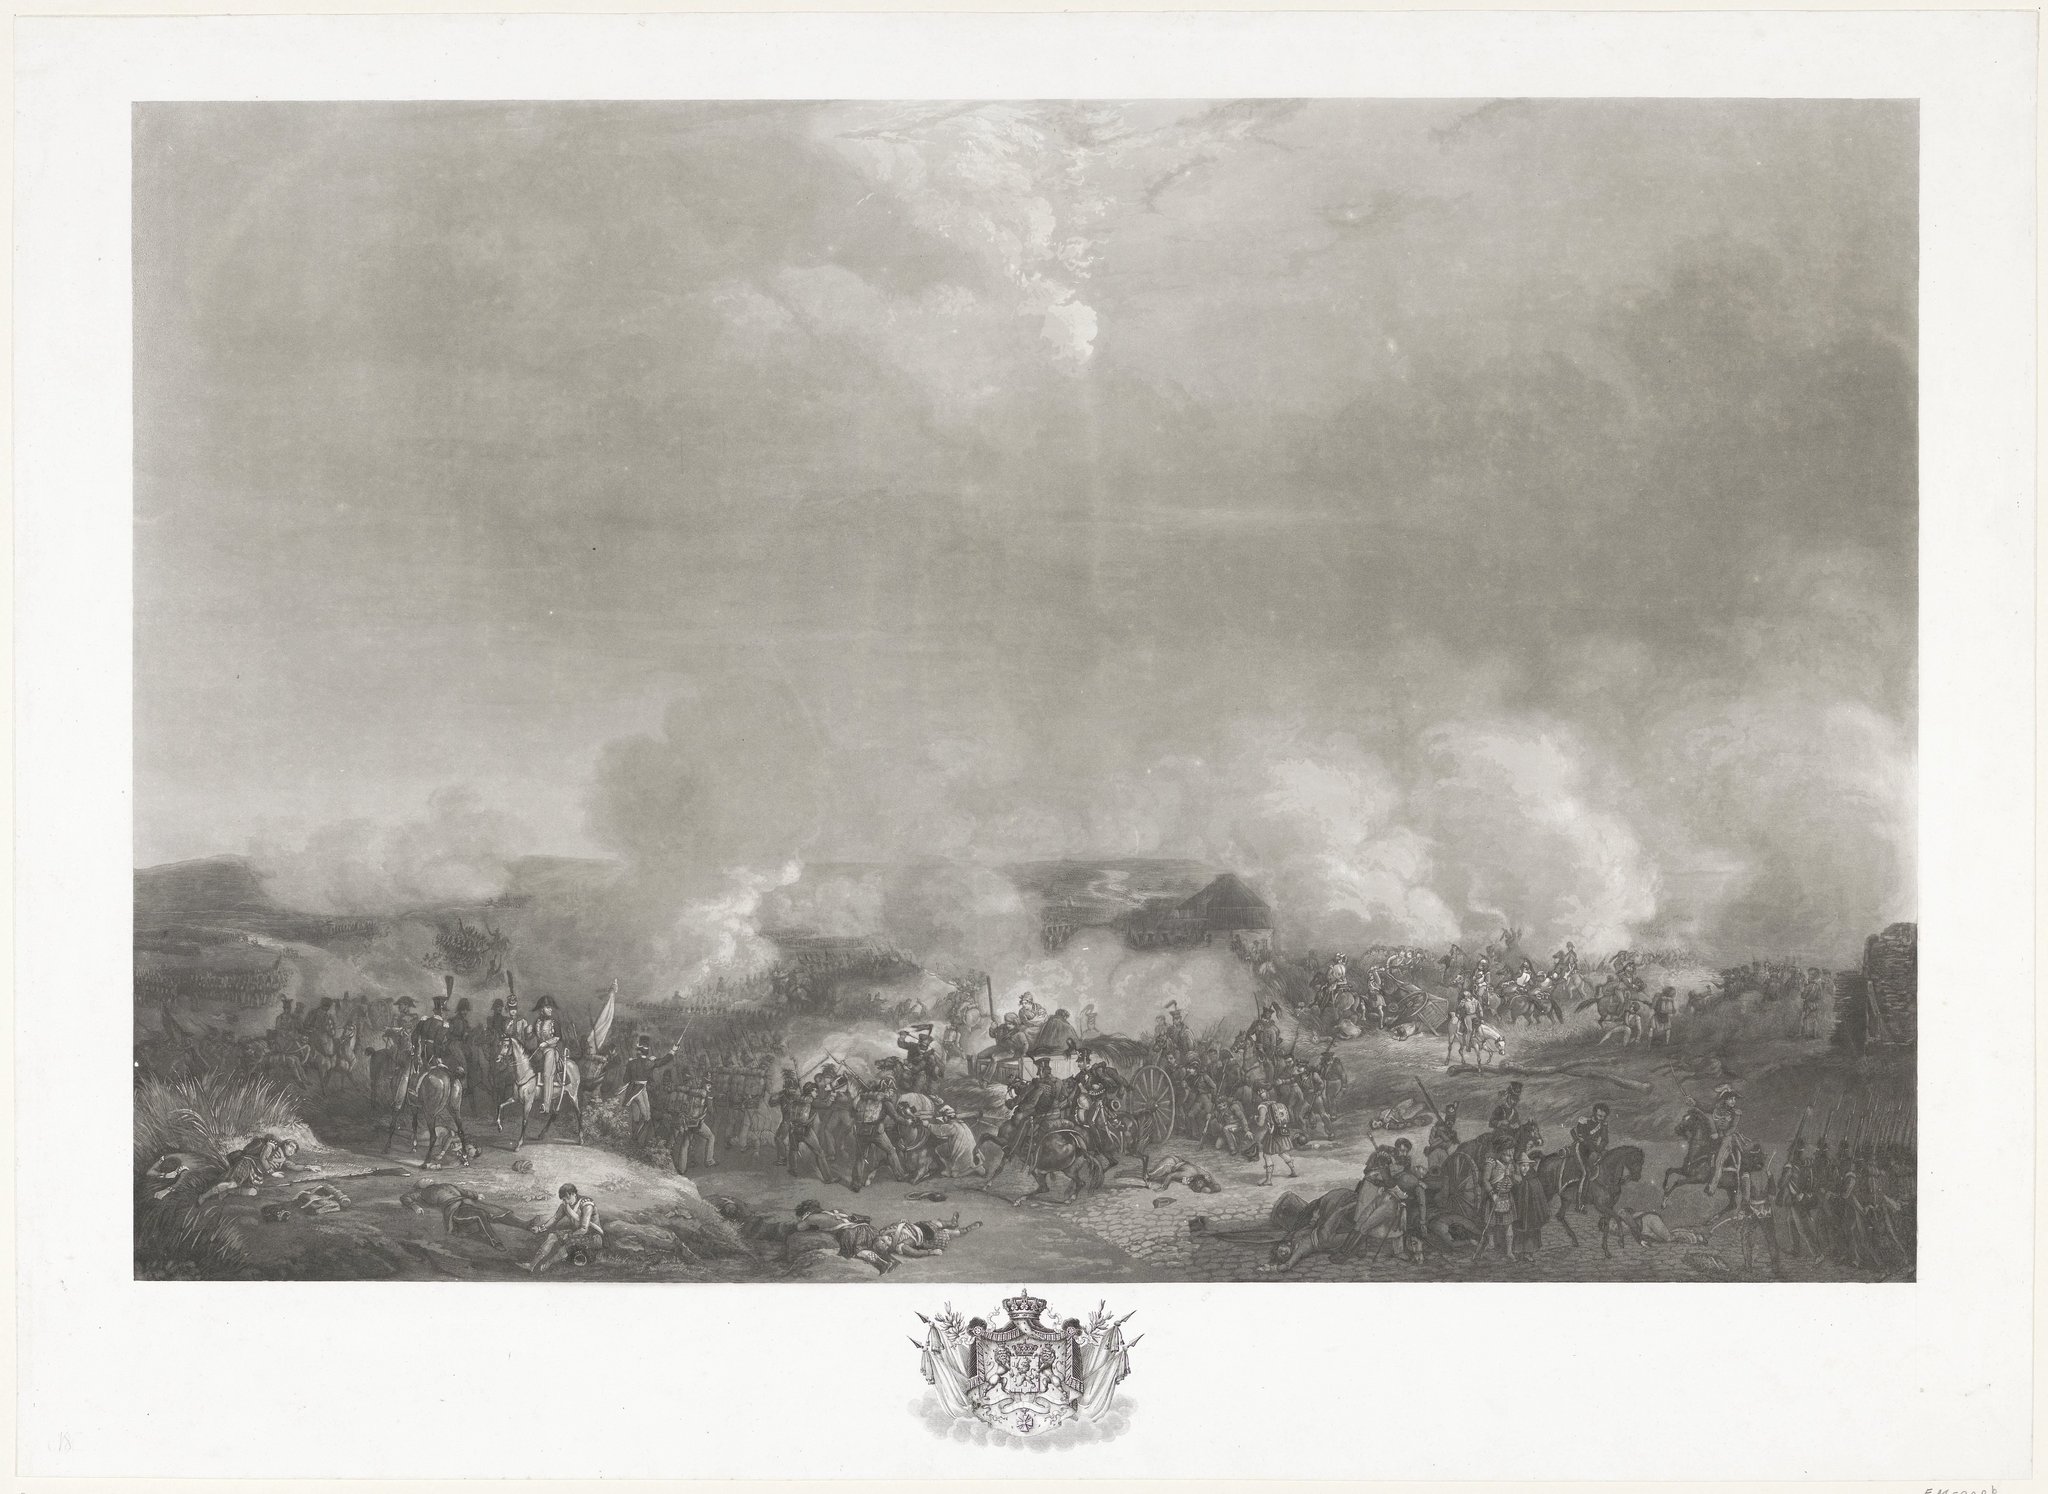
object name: history print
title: Prins van Oranje in de slag bij Quatre-Bras, 1815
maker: johann hürlimann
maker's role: print maker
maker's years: 1793-1850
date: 1825-1826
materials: paper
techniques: aquatint, etching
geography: brussels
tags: william ii of the netherlands, battle (+ land forces)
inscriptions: collector's mark: Lugt 2228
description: De prins van Oranje te paard overziet het slagveld tijdens de slag bij Quatre-Bras, 16 juni 1815. Links de prins te paard op een heuveltje omgeven door zijn staf. Centraal gevechten rondom een boerenwagen. Rechts gevechten tussen Bergschotten en Franse kurassiers. Centraal onderaan het wapen van koning Willem I. Behoort bij een serie platen over de inhuldiging van Willem I in Brussel. Zie ook de pendant.